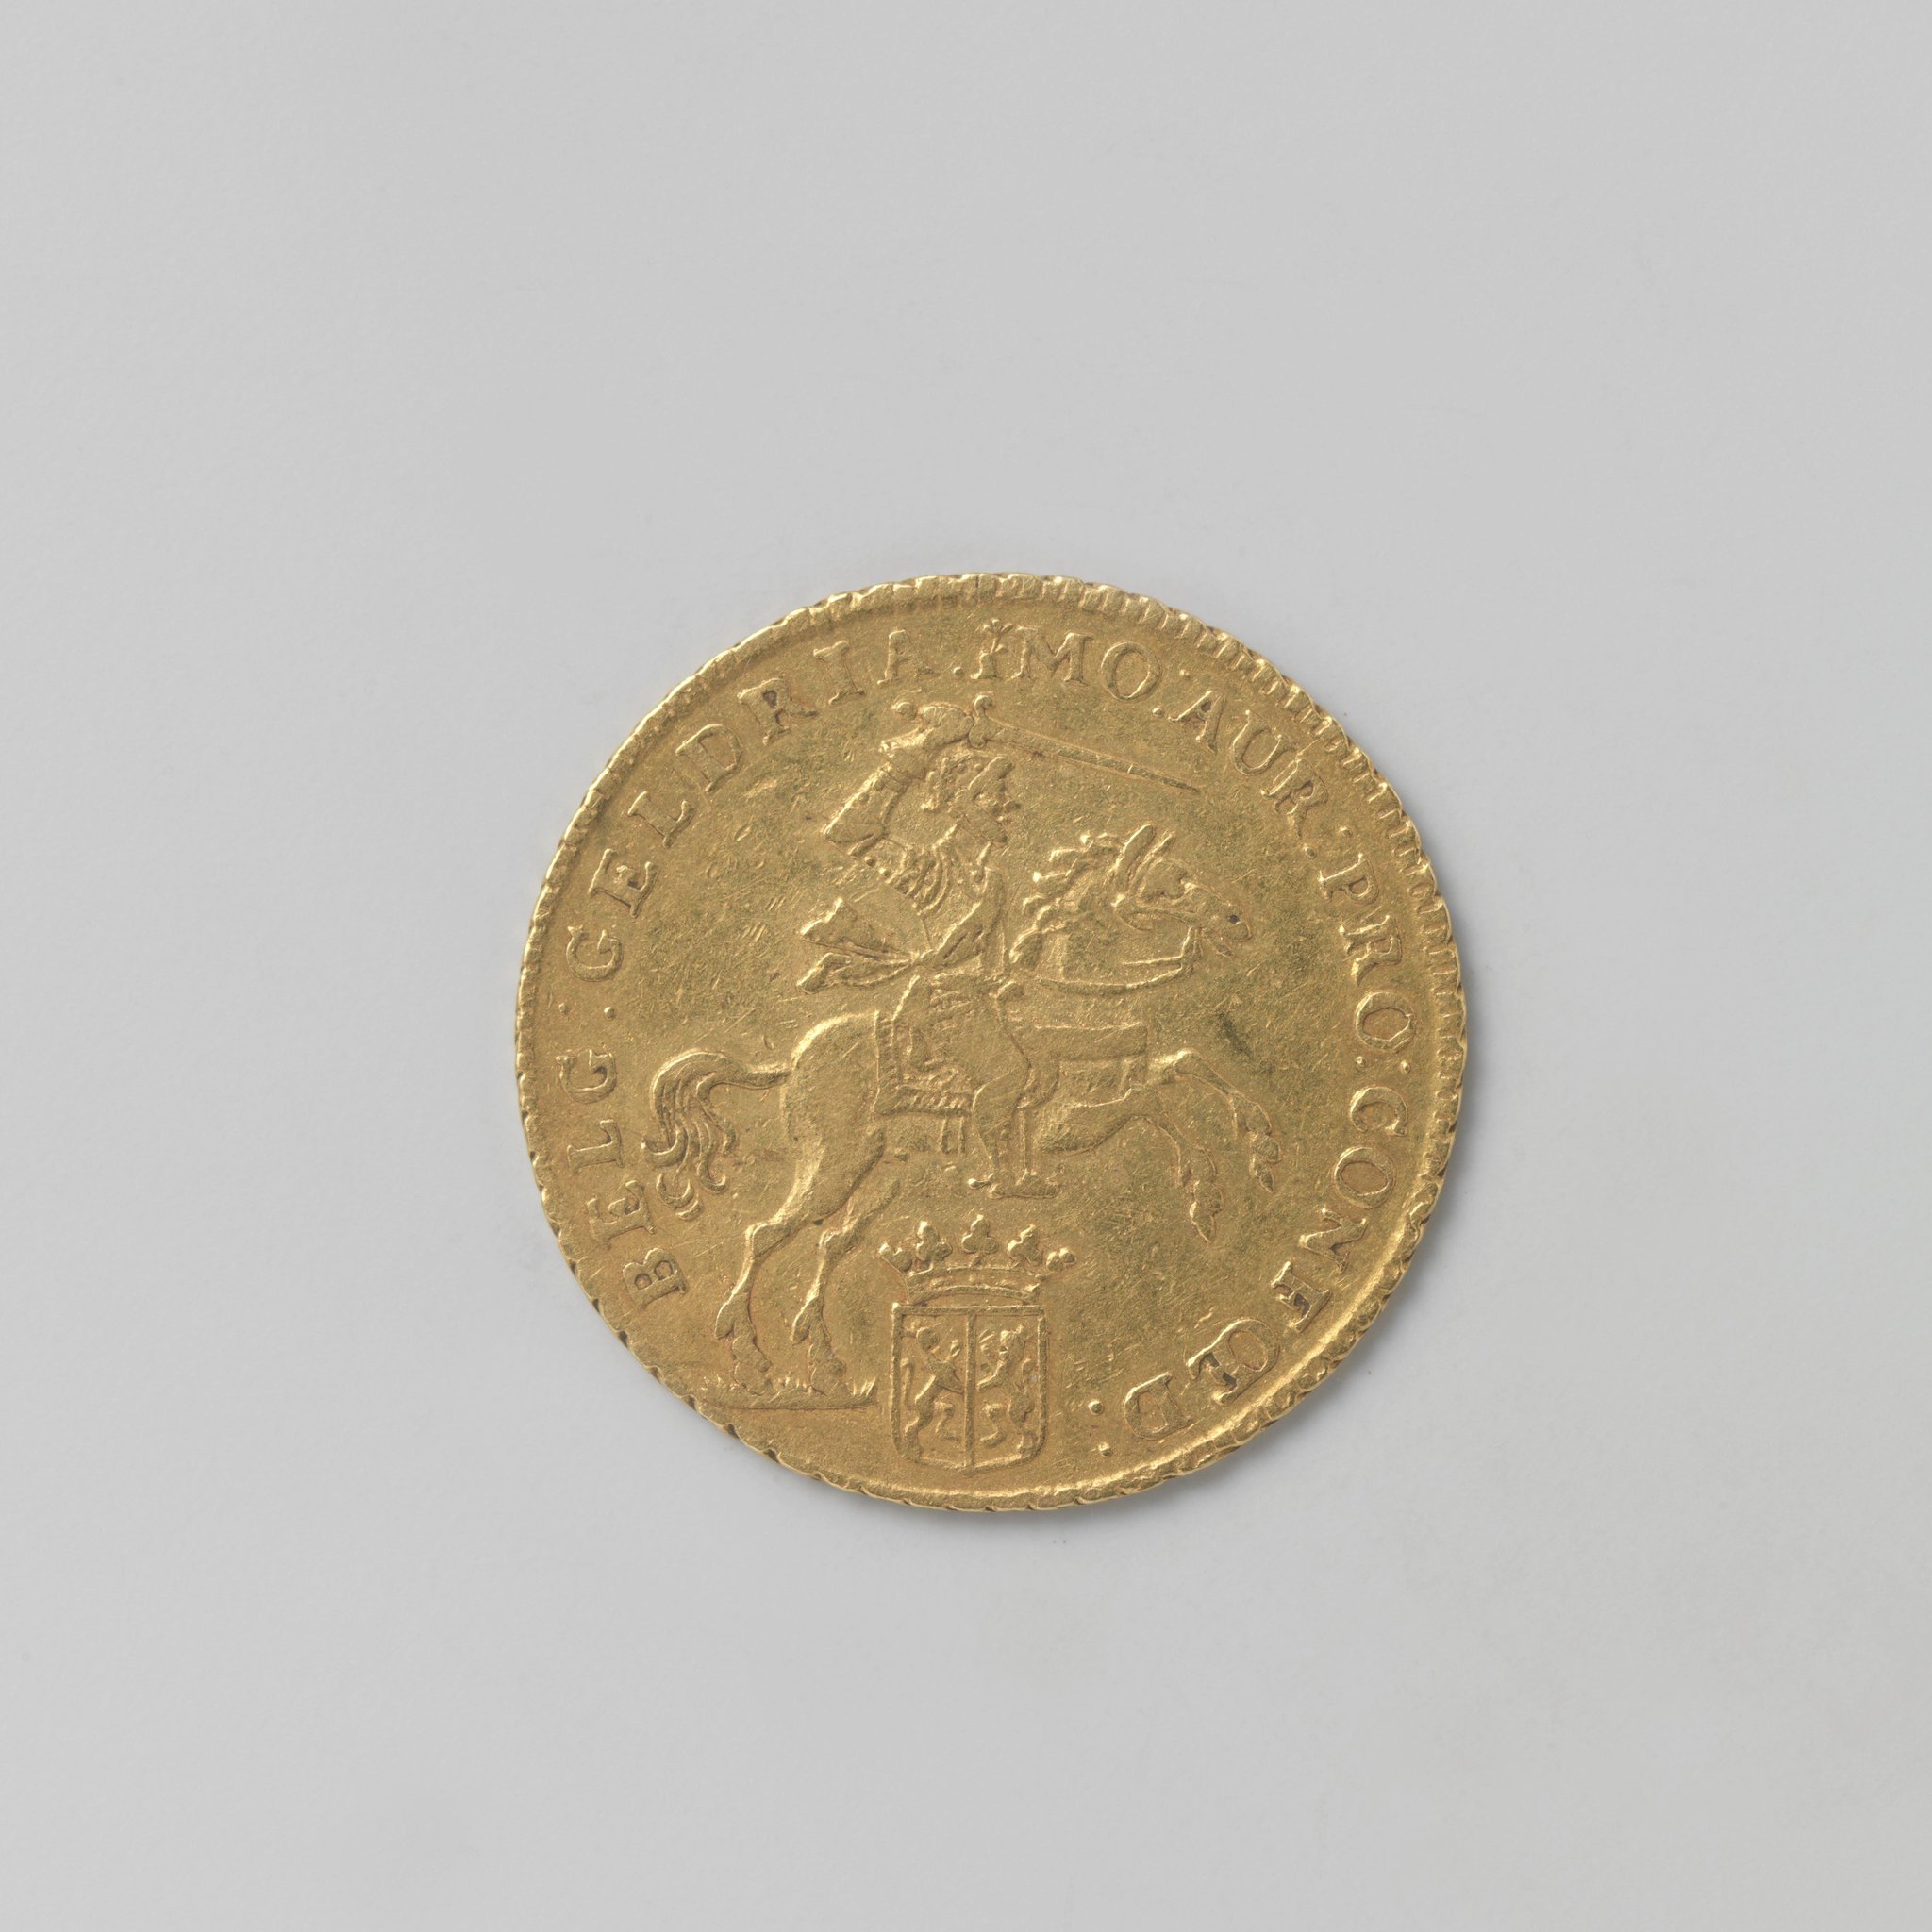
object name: coin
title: Gelderse halve gouden rijder, 1760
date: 1760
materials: gold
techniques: striking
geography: harderwijk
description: Gouden munt. Voorzijde: ruiter met zwaard naar rechts, daaronder gekroond Gelders wapenschild. Keerzijde: tussen waarde-aanduiding gekroond generaliteitswapenschild. Boven kroon jaartal. Kabelrand.